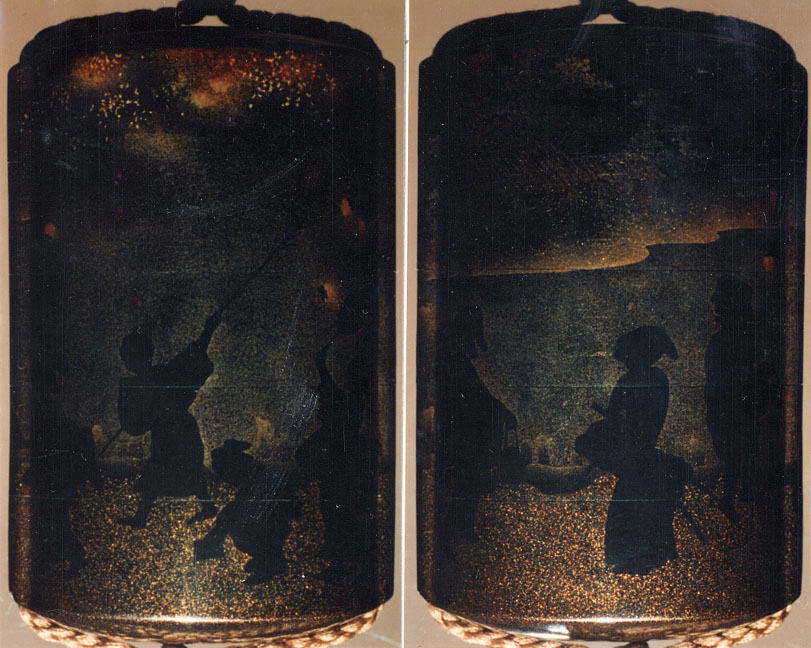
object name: inrō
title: Case (Inrō) with Design of People Catching Fireflies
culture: japanese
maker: koma kōryū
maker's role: artist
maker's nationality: japanese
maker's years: -1796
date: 1801-1900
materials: lacquer, metal, stone, wood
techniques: carving, fundame, inlay, polish, roiro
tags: human figures